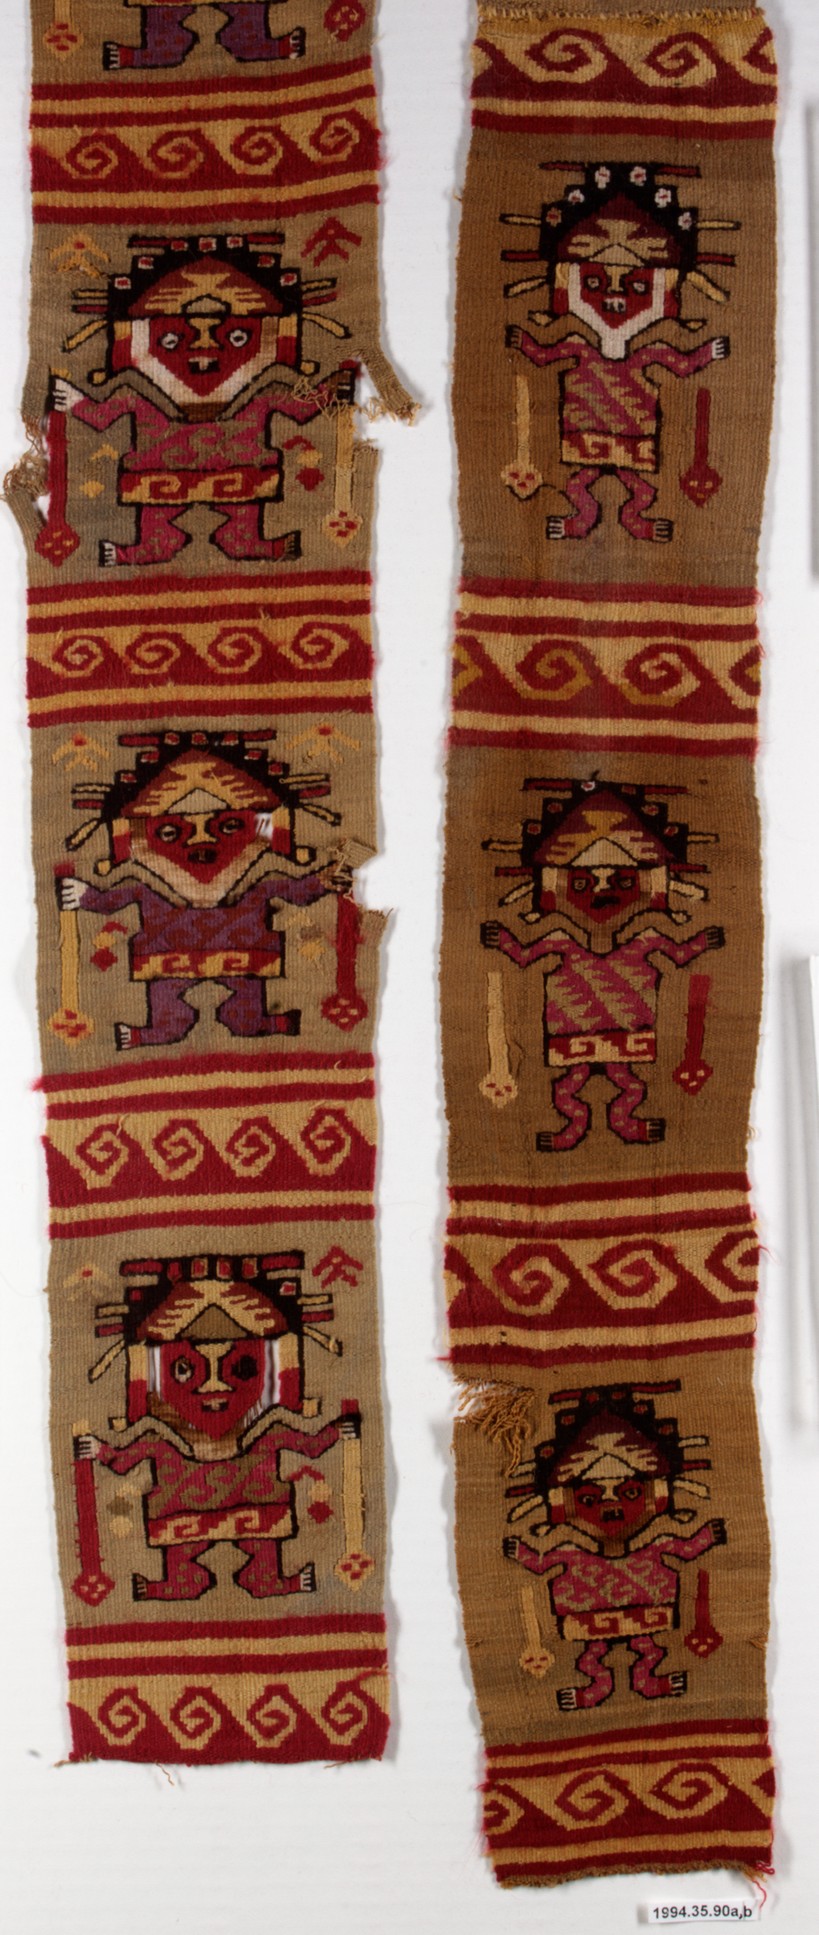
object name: sash fragment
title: Sash Fragments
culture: peruvian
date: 1301-1533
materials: cotton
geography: peru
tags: human figures